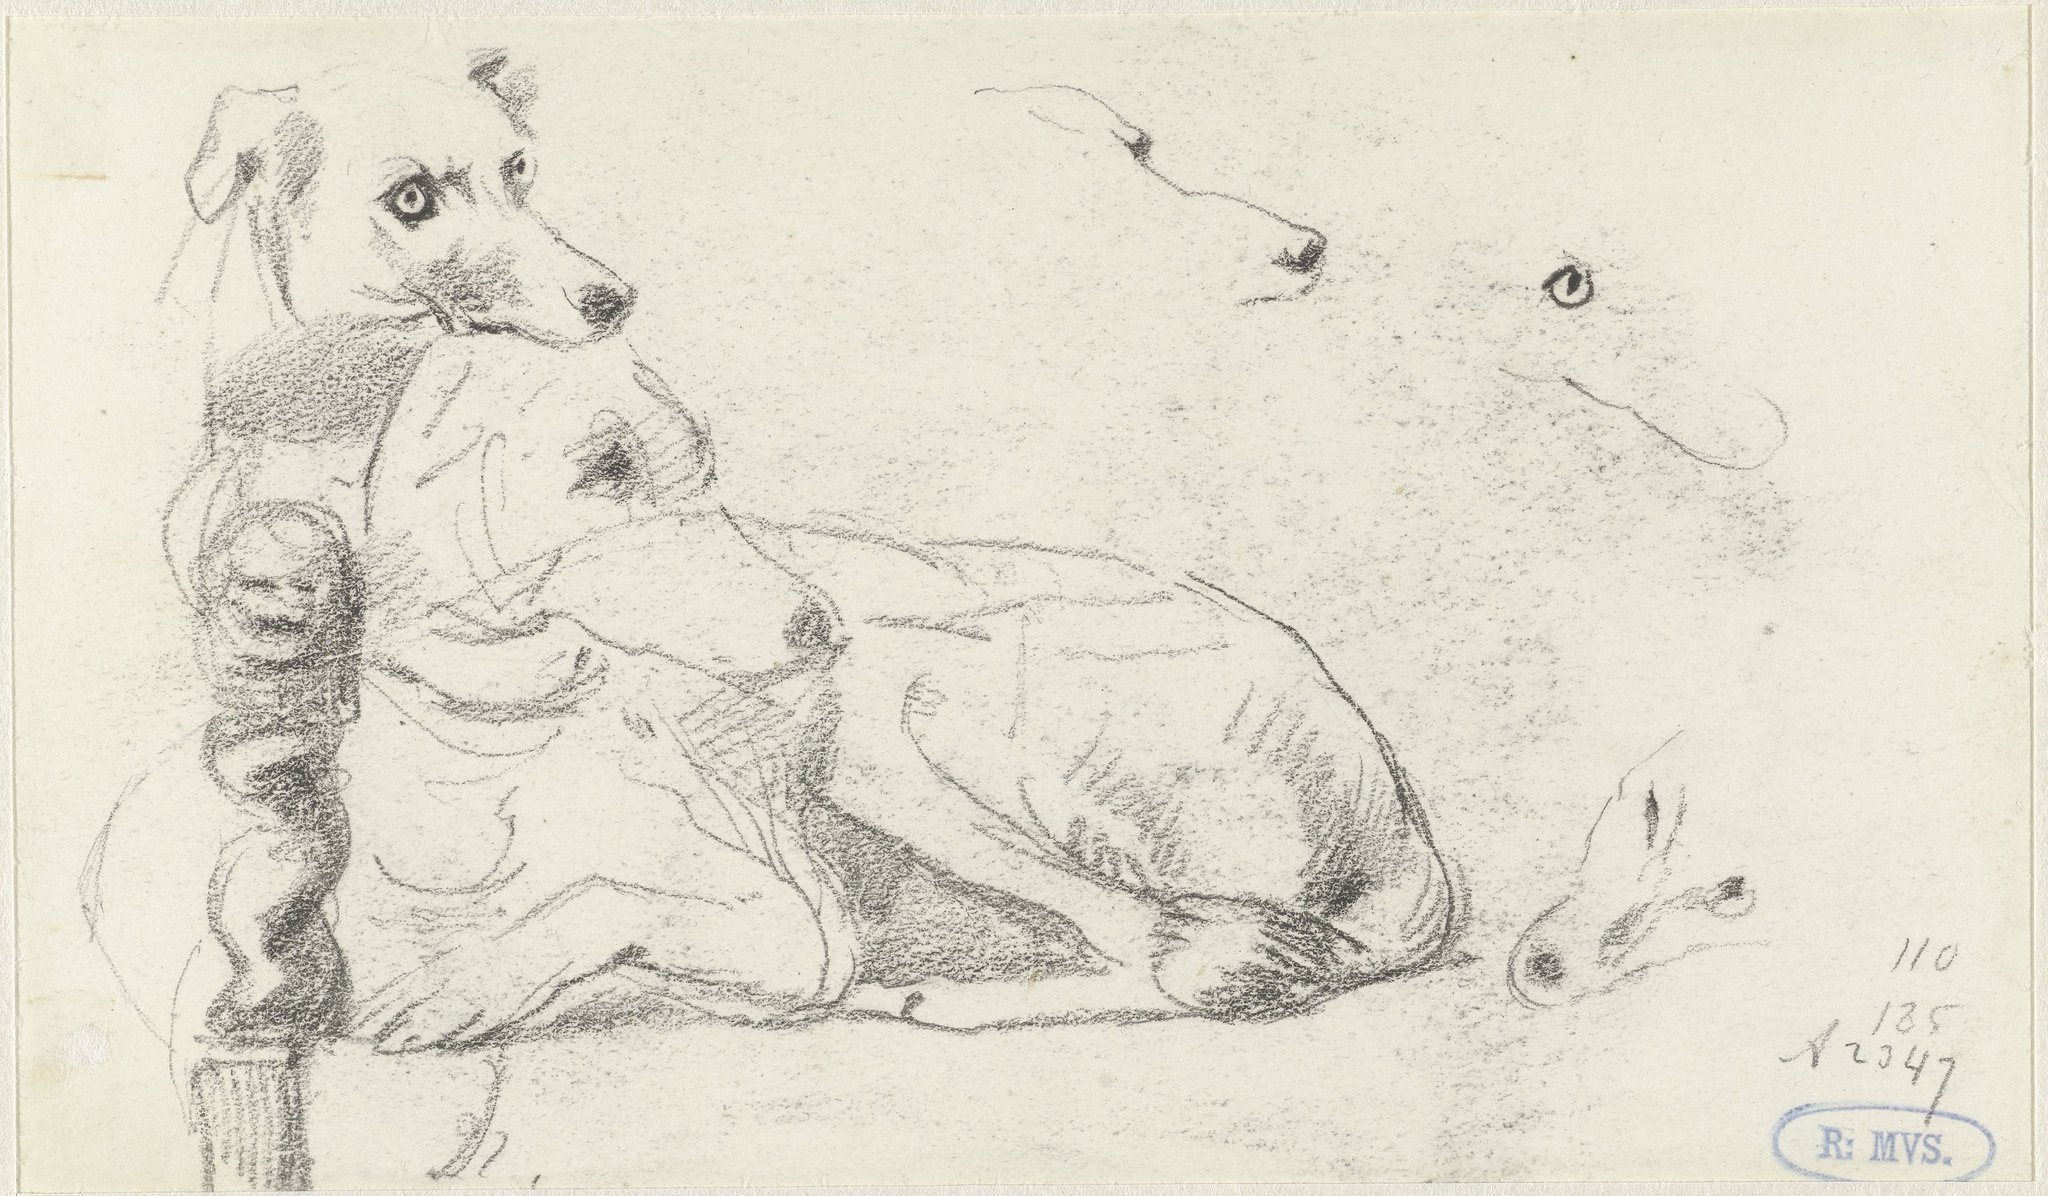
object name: drawing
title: Schetsen van een hond, liggend op een stoel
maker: guillaume anne van der brugghen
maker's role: draughtsman, print maker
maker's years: 1812-1891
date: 1821-1890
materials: chalk, paper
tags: dog